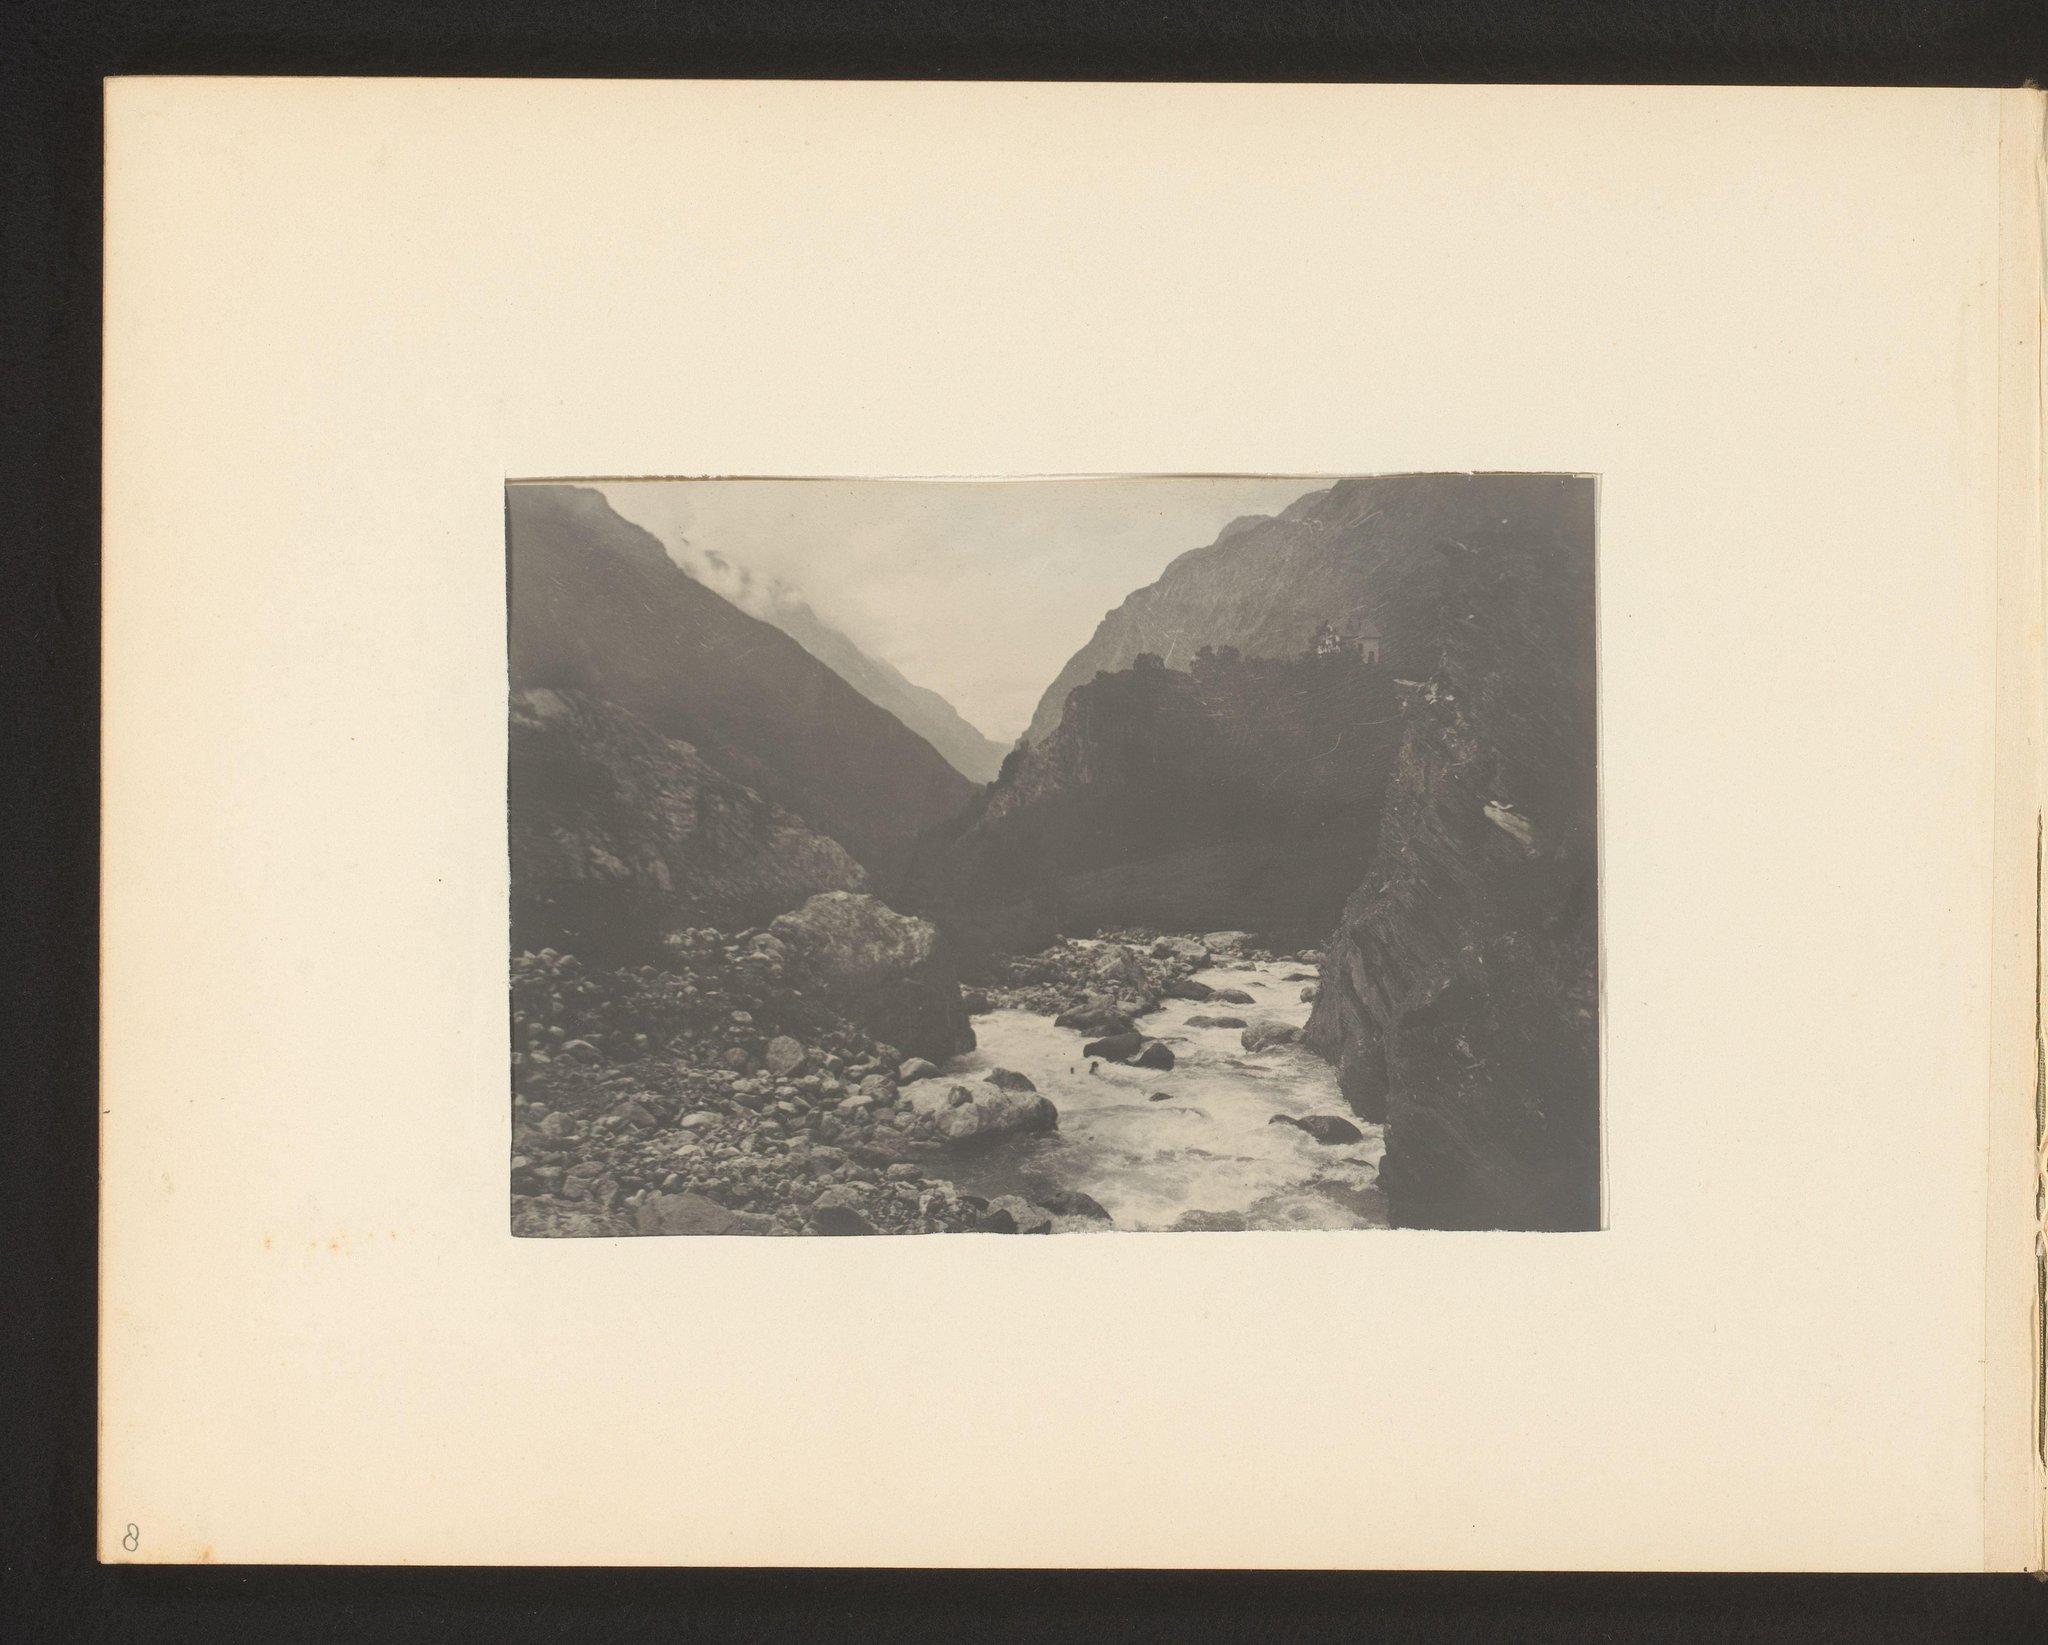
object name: album leaf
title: Landschap met een beek en een huis dat op een van de bergkammen staat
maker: Anonymous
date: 1900-1930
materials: photographic support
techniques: gelatin silver print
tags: rural housing, e.g. country-house, villa, cottage, brook, mountains